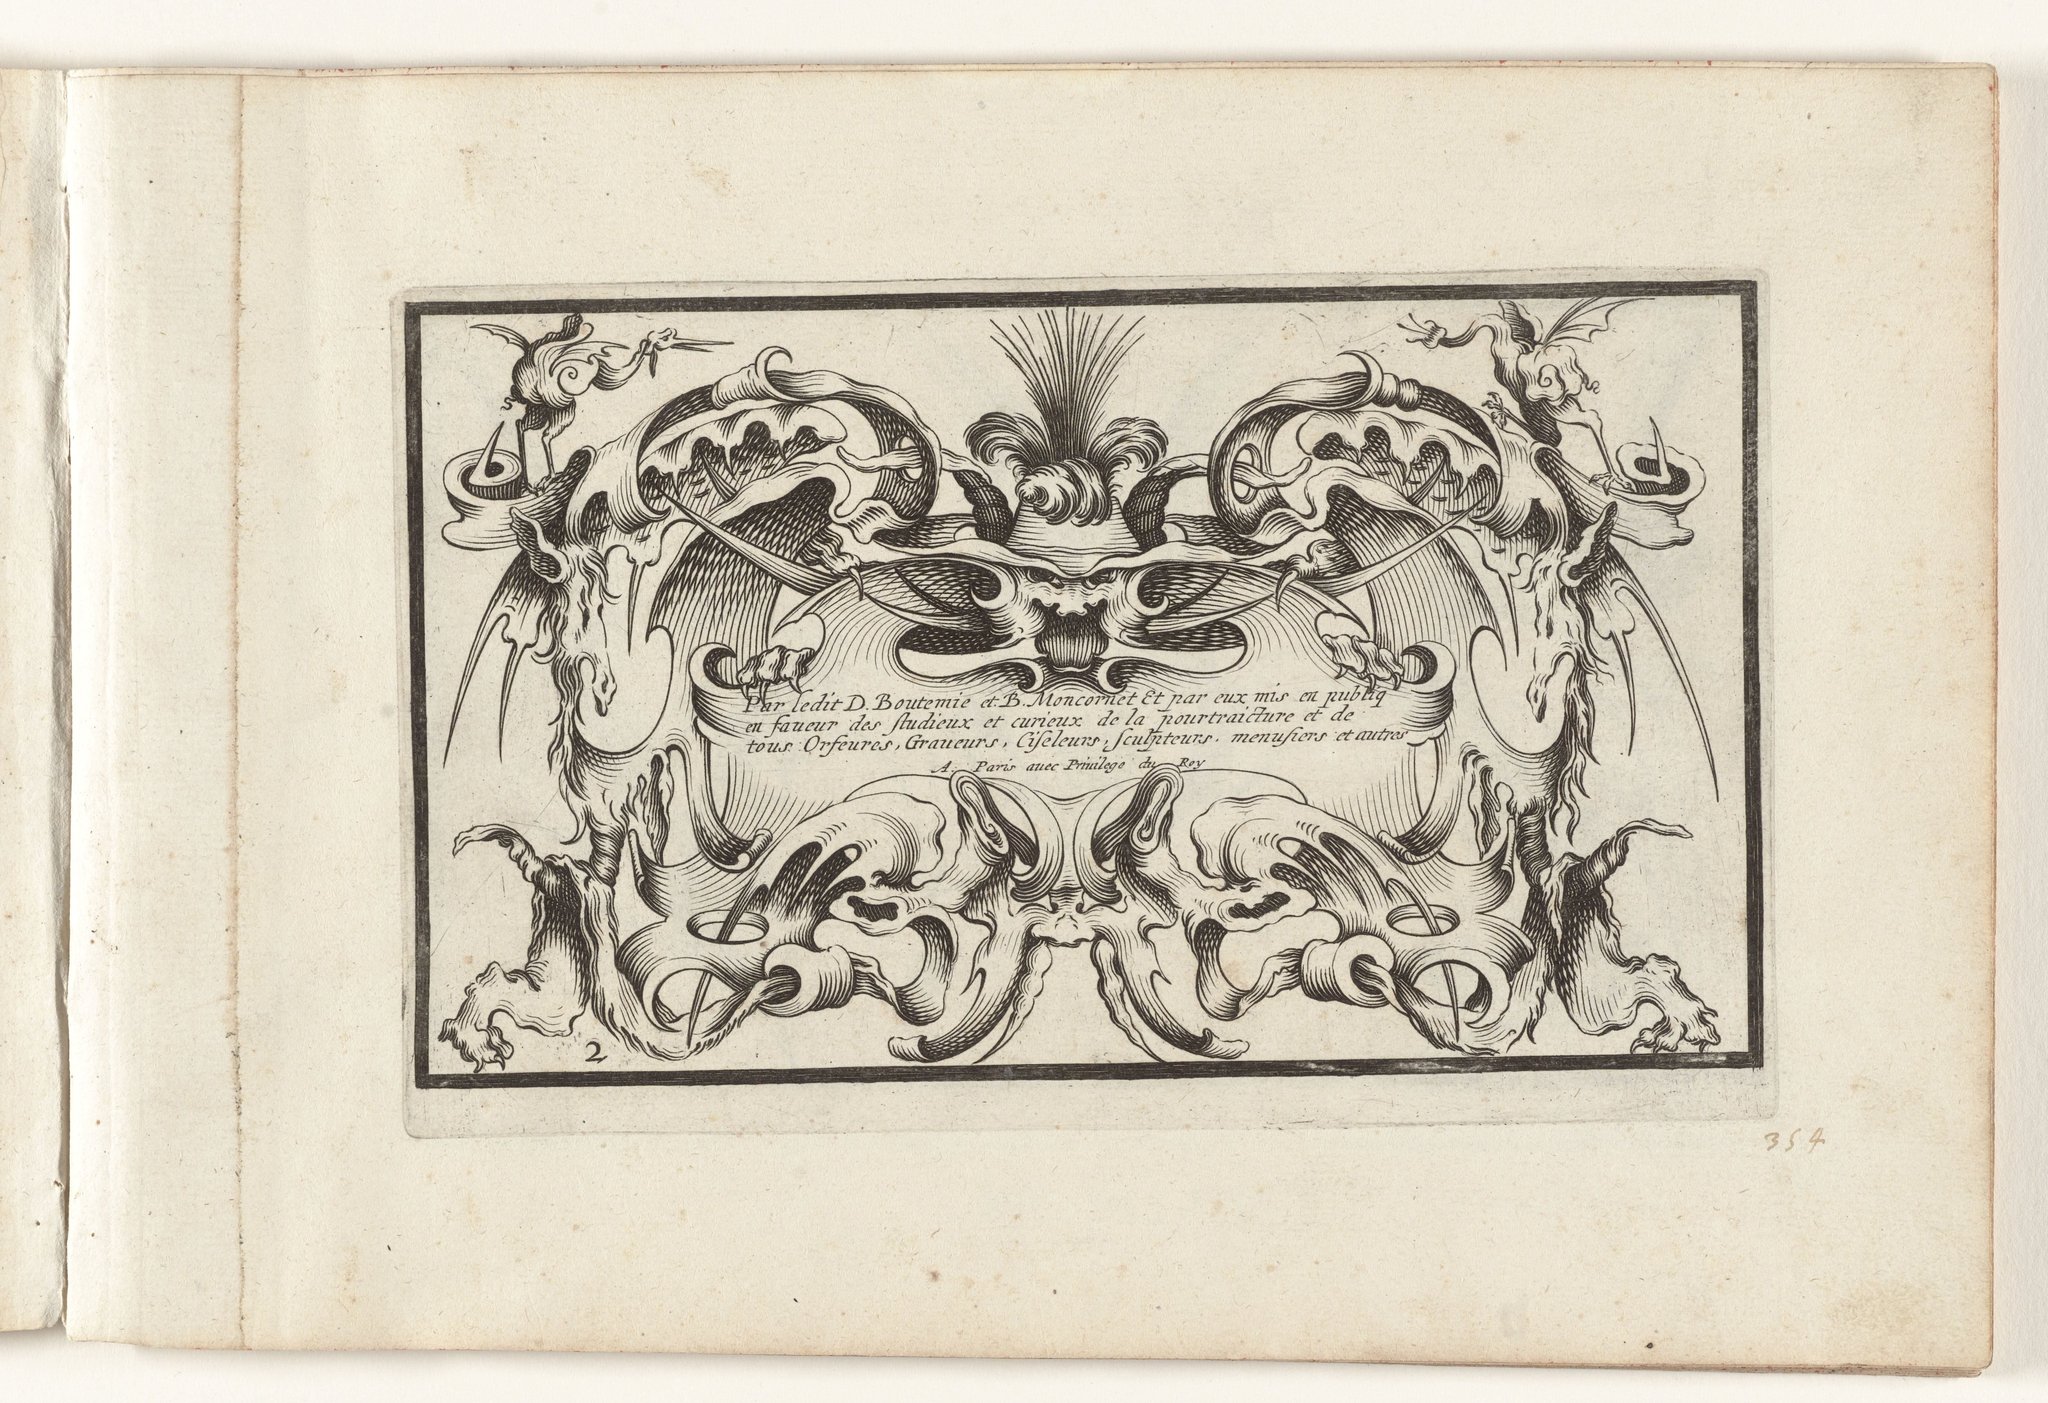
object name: album leaf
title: Ontwerpen voor hoofddeksels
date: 1636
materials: paper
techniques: engraving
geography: paris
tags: ornaments ~ art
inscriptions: number: ‘354’, collector's mark: Lugt 2228, collector's mark: Lugt 2760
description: Deze prent maakt deel uit van een album.